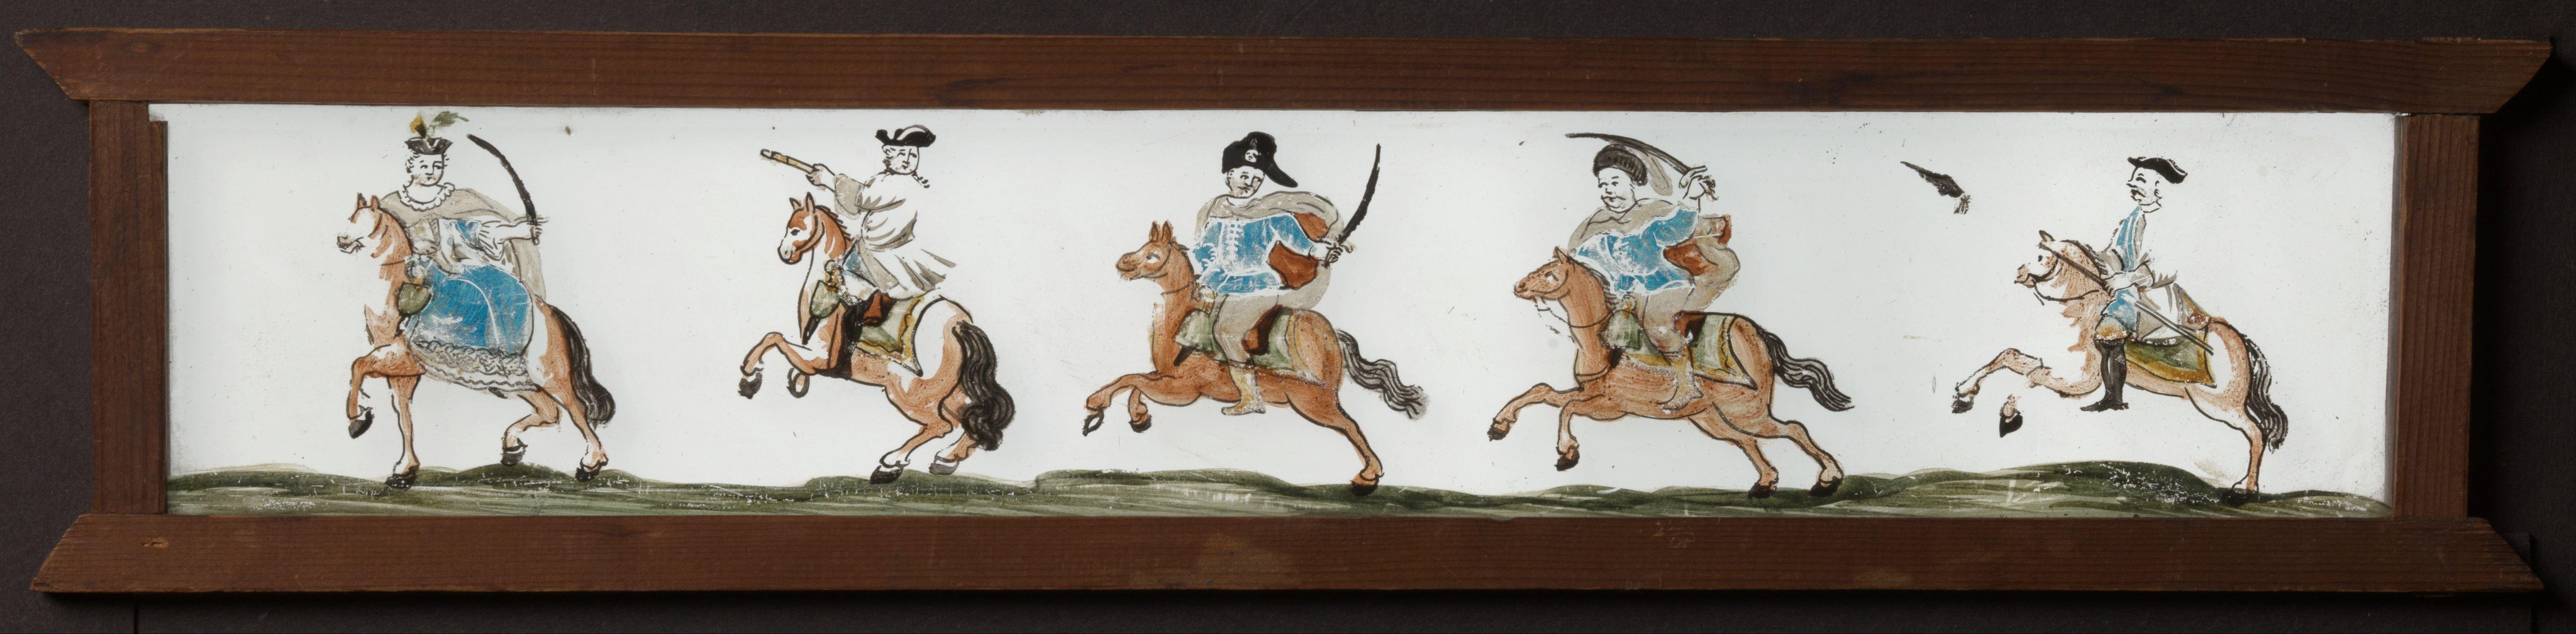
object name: lantern slide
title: Vijf personen op paarden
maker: Anonymous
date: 1750-1800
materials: glass, wood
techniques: painted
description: Houten frame met glasplaat, gebruikt voor toverlantaarn. Vijf personen op paarden. links = vrouw op een paard, benen aan één zijde van het paard. In haar hand heeft ze een sabel. 2e van links = steigerend paard met een man op zijn rug. midden = rennend paard met een man op zijn rug, die een sabel in zijn hand heeft. 2e van rechts = rennend paard met een chinees uitziende man op zijn rug. Hij heeft een sabel in zijn hand. rechts = rennend paard met een man op zijn rug.